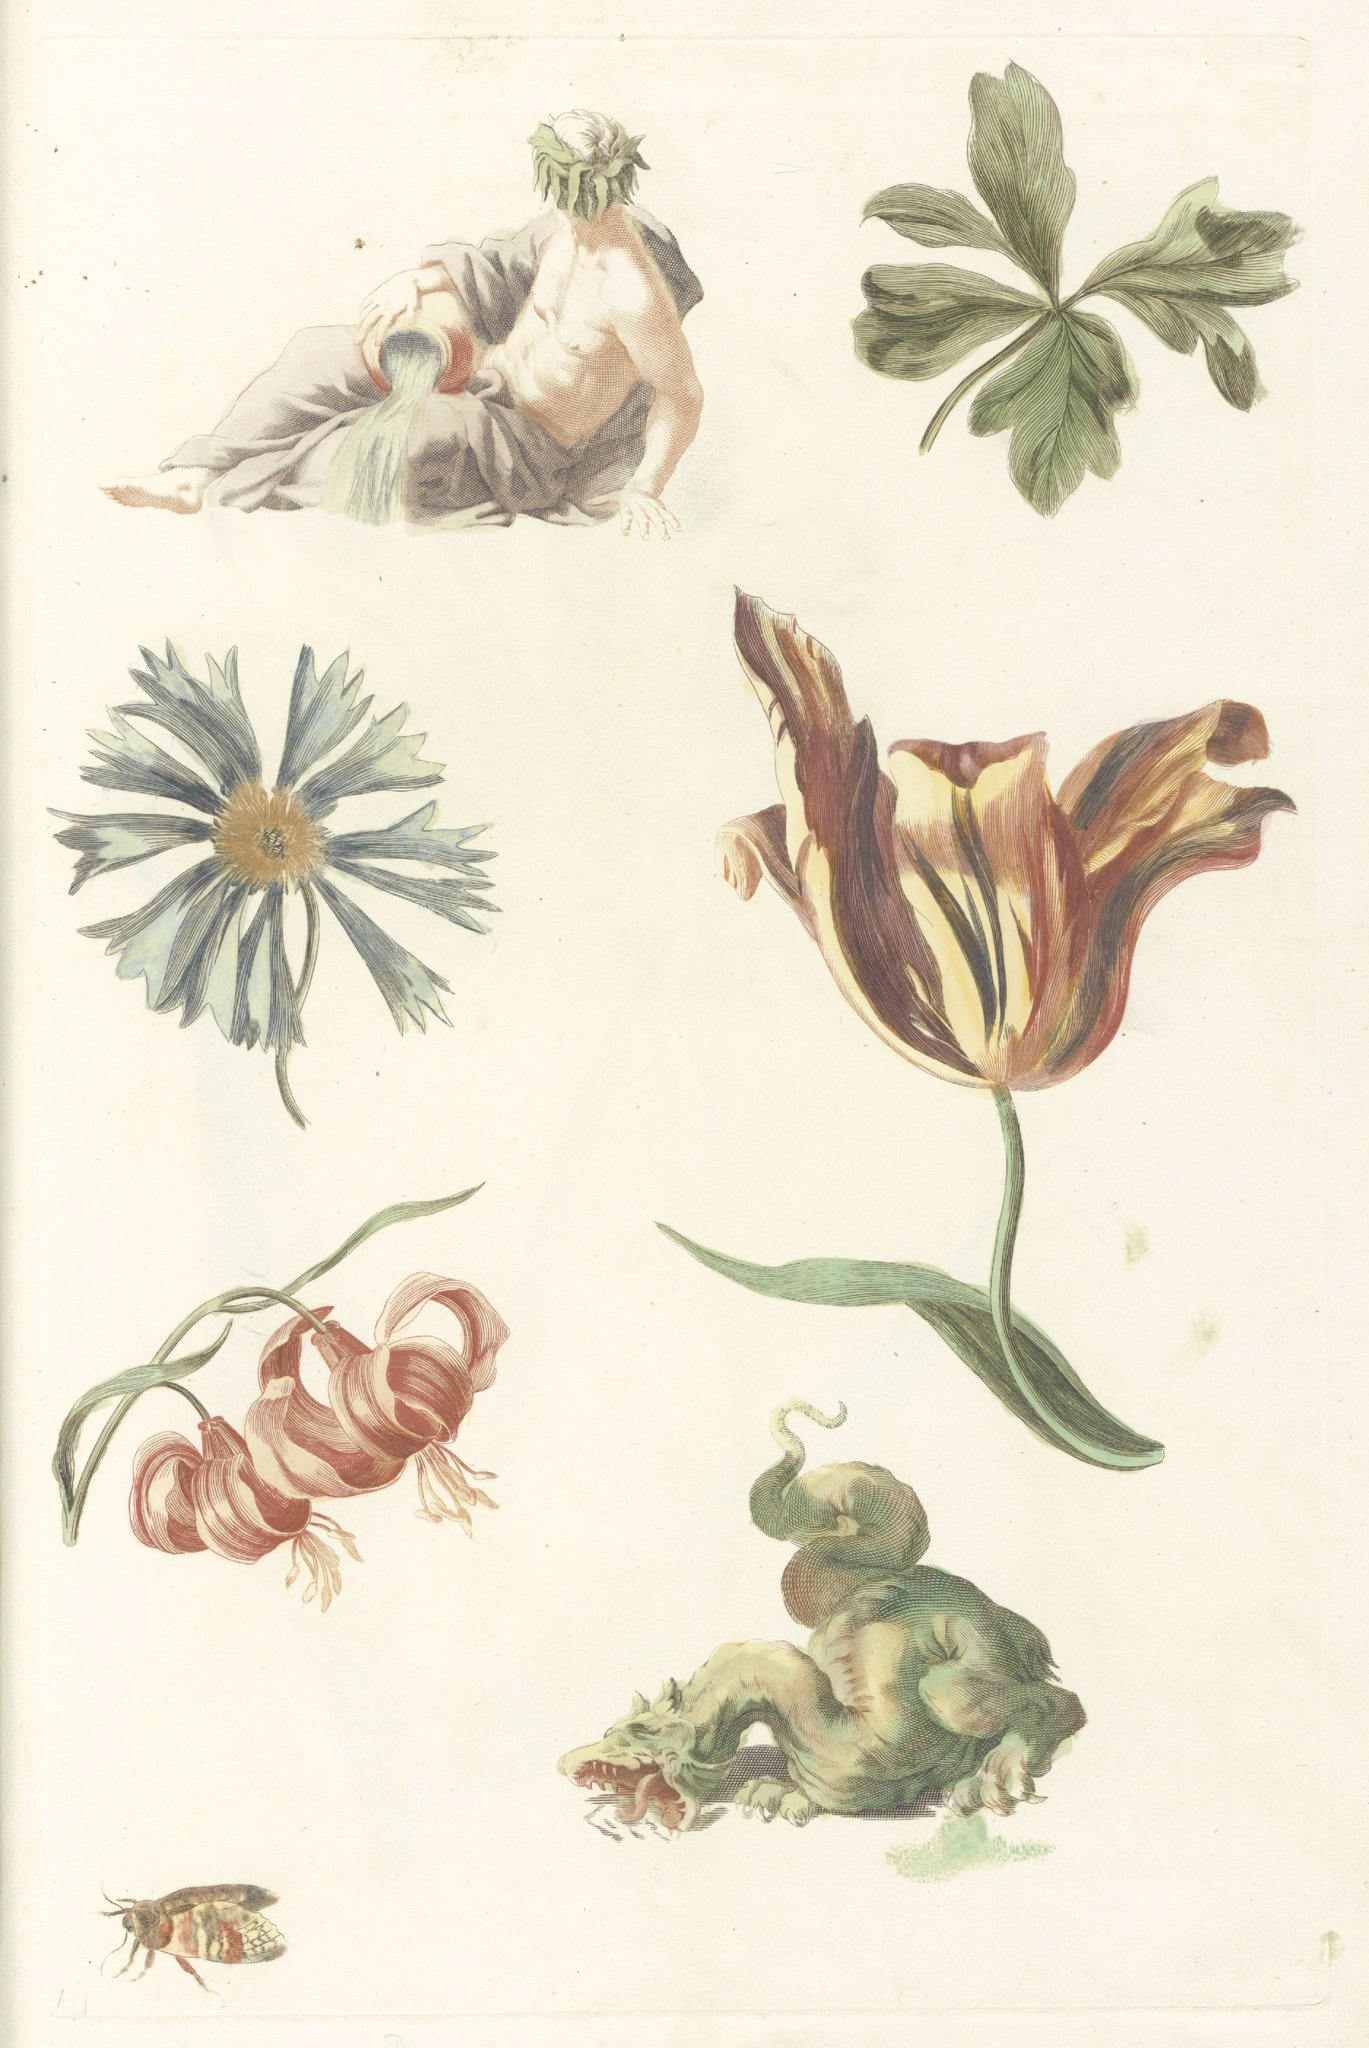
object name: print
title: Riviergod, een draak en vier bloemen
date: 1688-1698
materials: paper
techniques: printing, engraving, hand coloring, lithography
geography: netherlands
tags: river personified, 'fiumi' (ripa), insects: moth, lying on one side, with uplifted upper part of the body and leaning on the arm, dragon, flowers: tulip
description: Riviergod, vier bloemen, een mot en een draak. Deze prent maakt deel uit van een album.